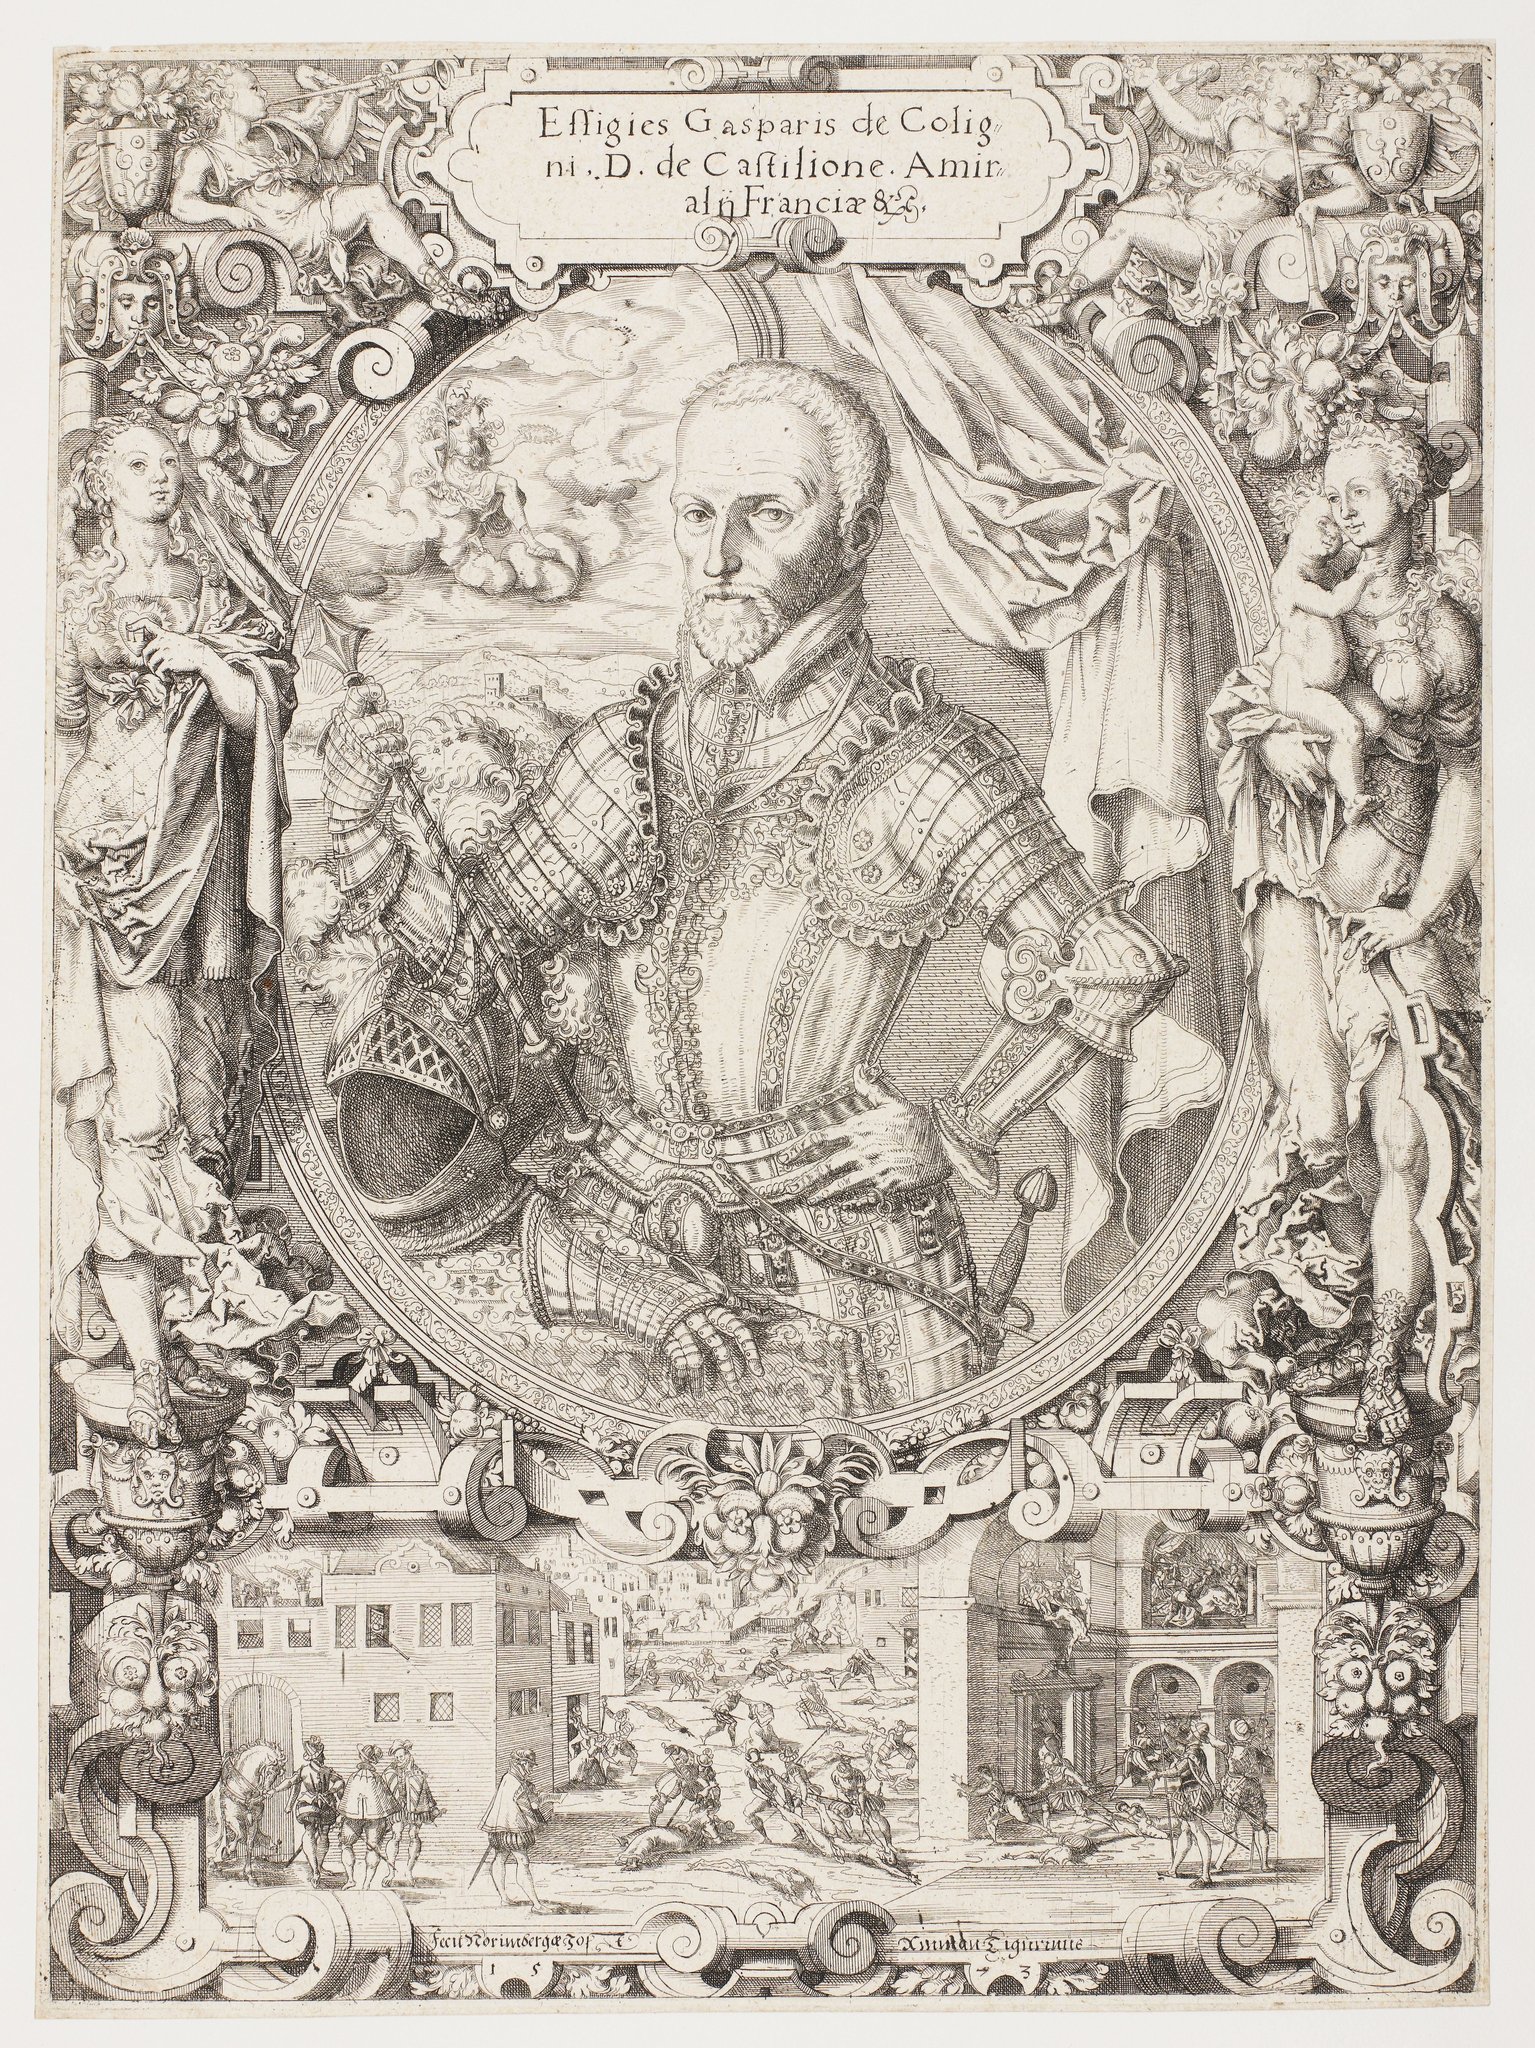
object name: print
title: Effigies Gasparis de Coligni (...)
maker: jost amman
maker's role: draughtsman, painter, print maker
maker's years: 1539-1591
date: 1573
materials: paper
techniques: etching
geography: nuremberg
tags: devotion, piety; 'divotione' (ripa), 'pietas'; 'pietà' (ripa), armour, historical persons, massacre ~ war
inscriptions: collector's mark: Lugt 2773, collector's mark: Lugt 636, collector's mark: Lugt 384, collector's mark: Lugt 52, collector's mark: Lugt 2228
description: In een omlijsting met links Vroomheid en rechts Caritas met onderin de slachtpartij tijdens de Bartholomeusnacht.